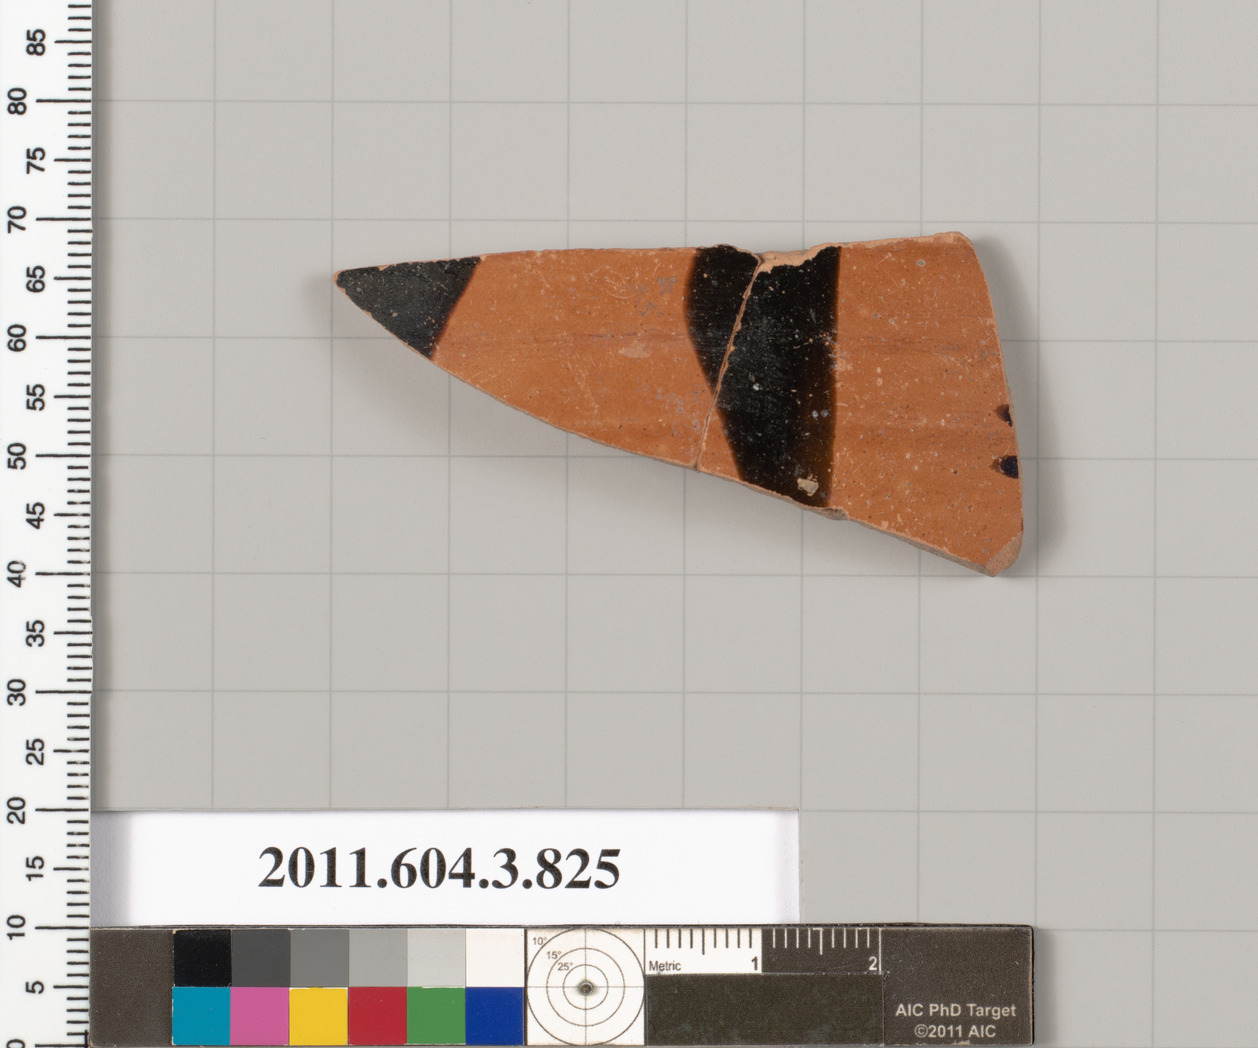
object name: lekythos fragment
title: Terracotta fragment of a lekythos (oil flask)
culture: greek, attic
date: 550-526 BCE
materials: terracotta